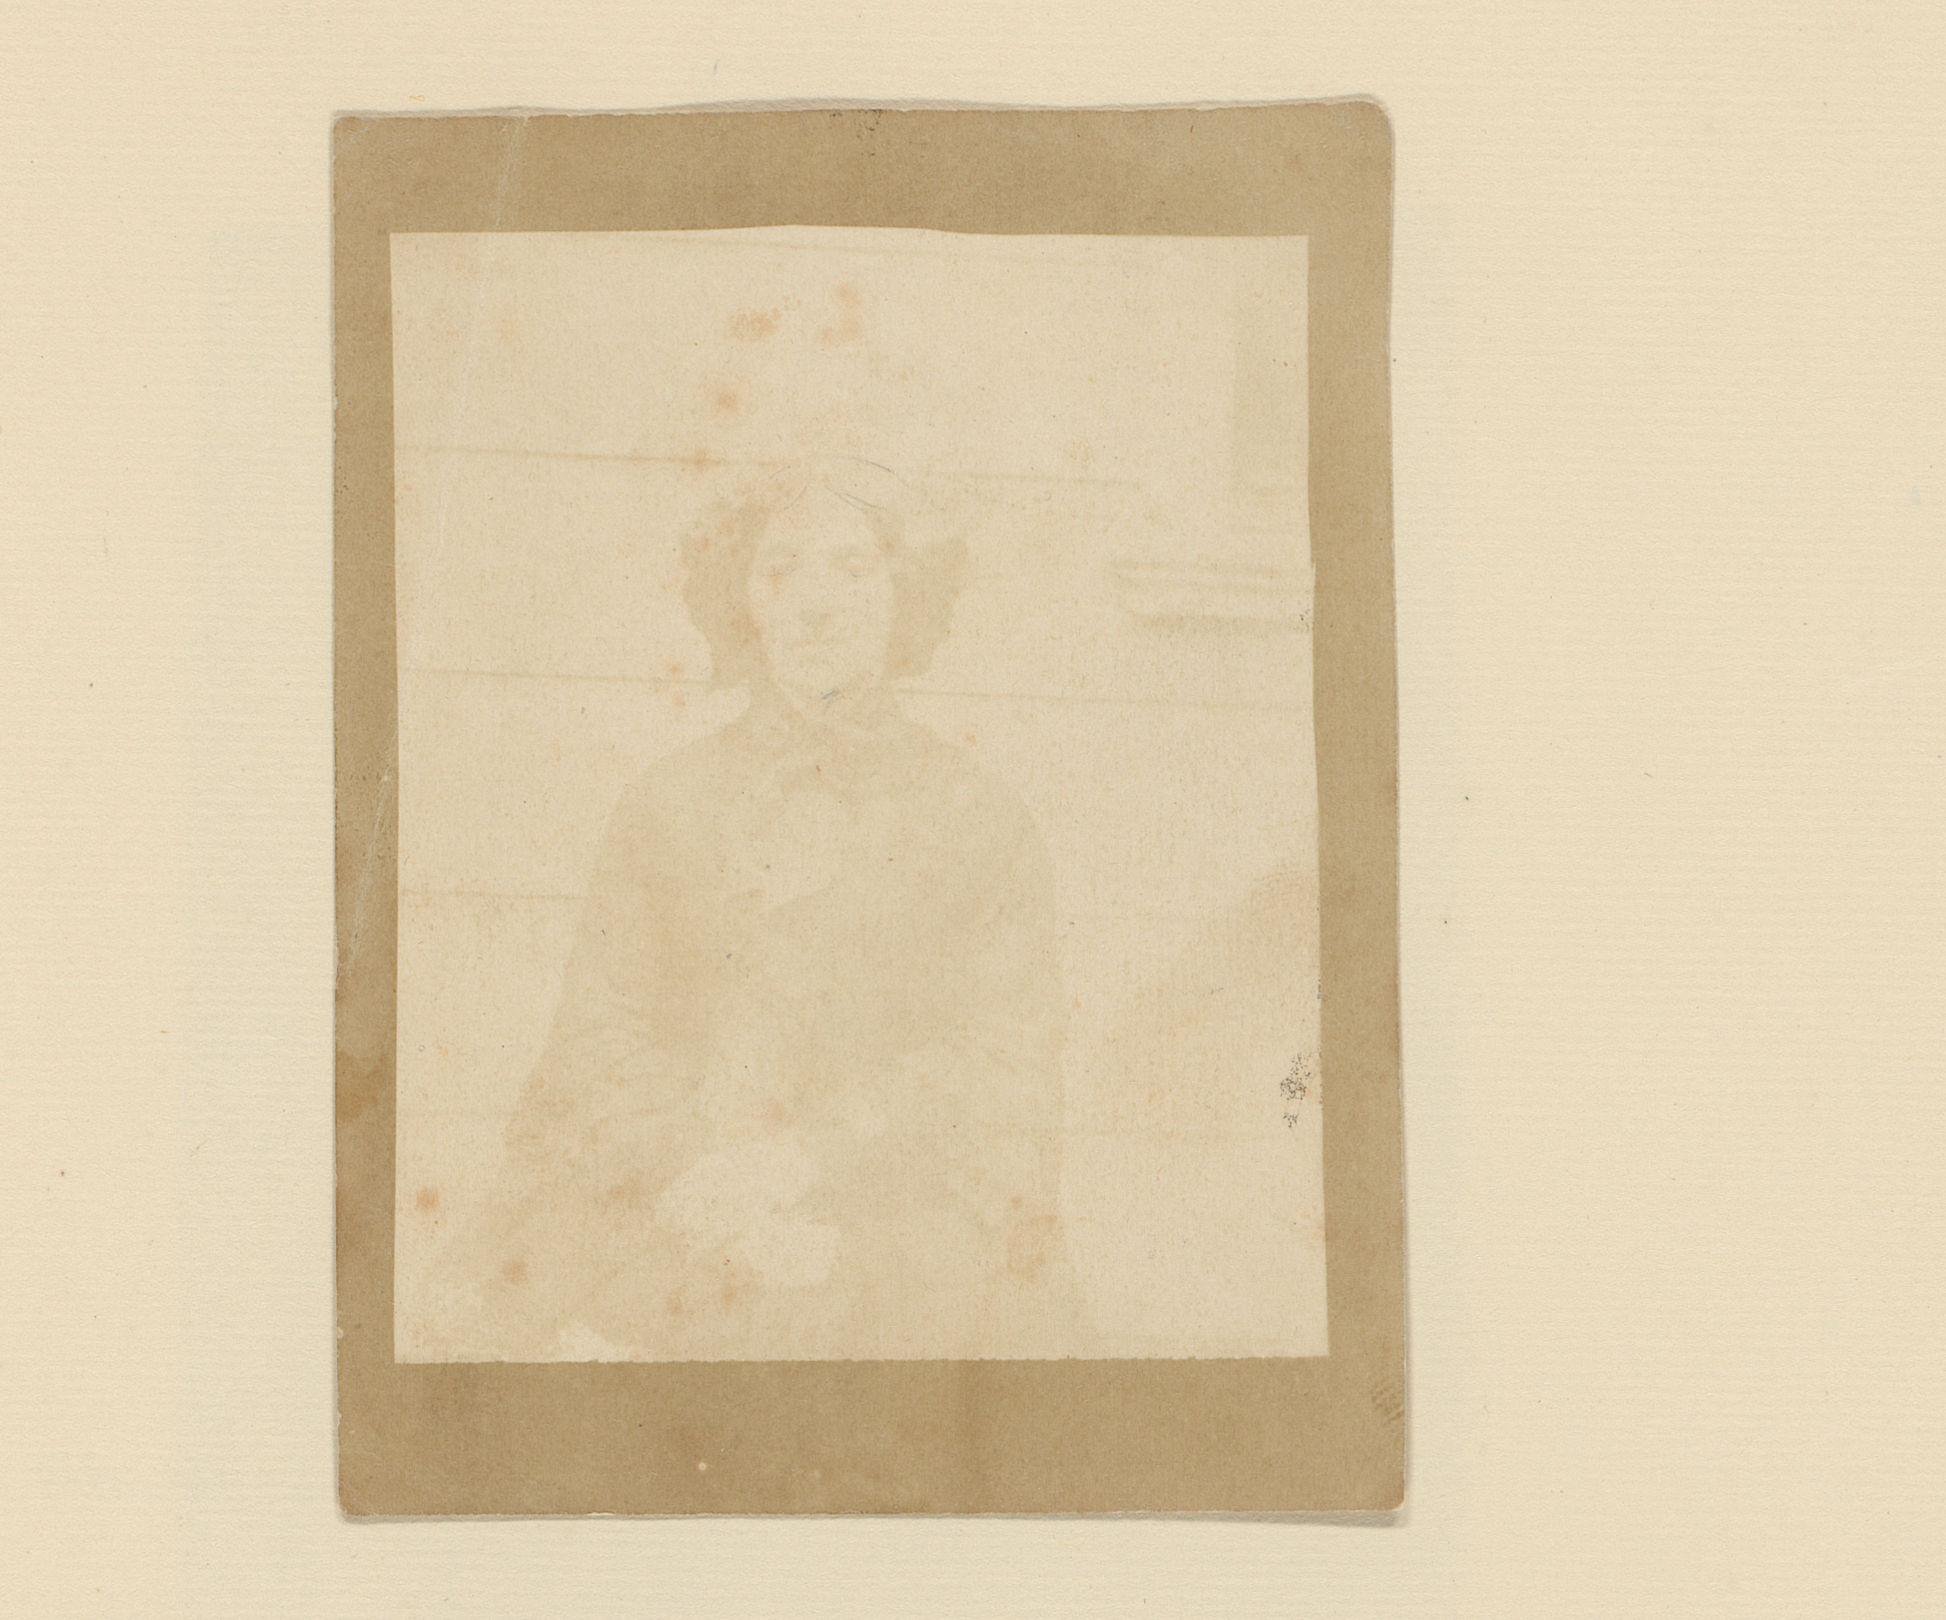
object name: photograph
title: Portret van een oudere vrouw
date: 1846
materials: cardboard, paper, photographic support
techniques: salted paper print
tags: historical persons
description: de vrouw is vermoedelijk de moeder van de fotograaf